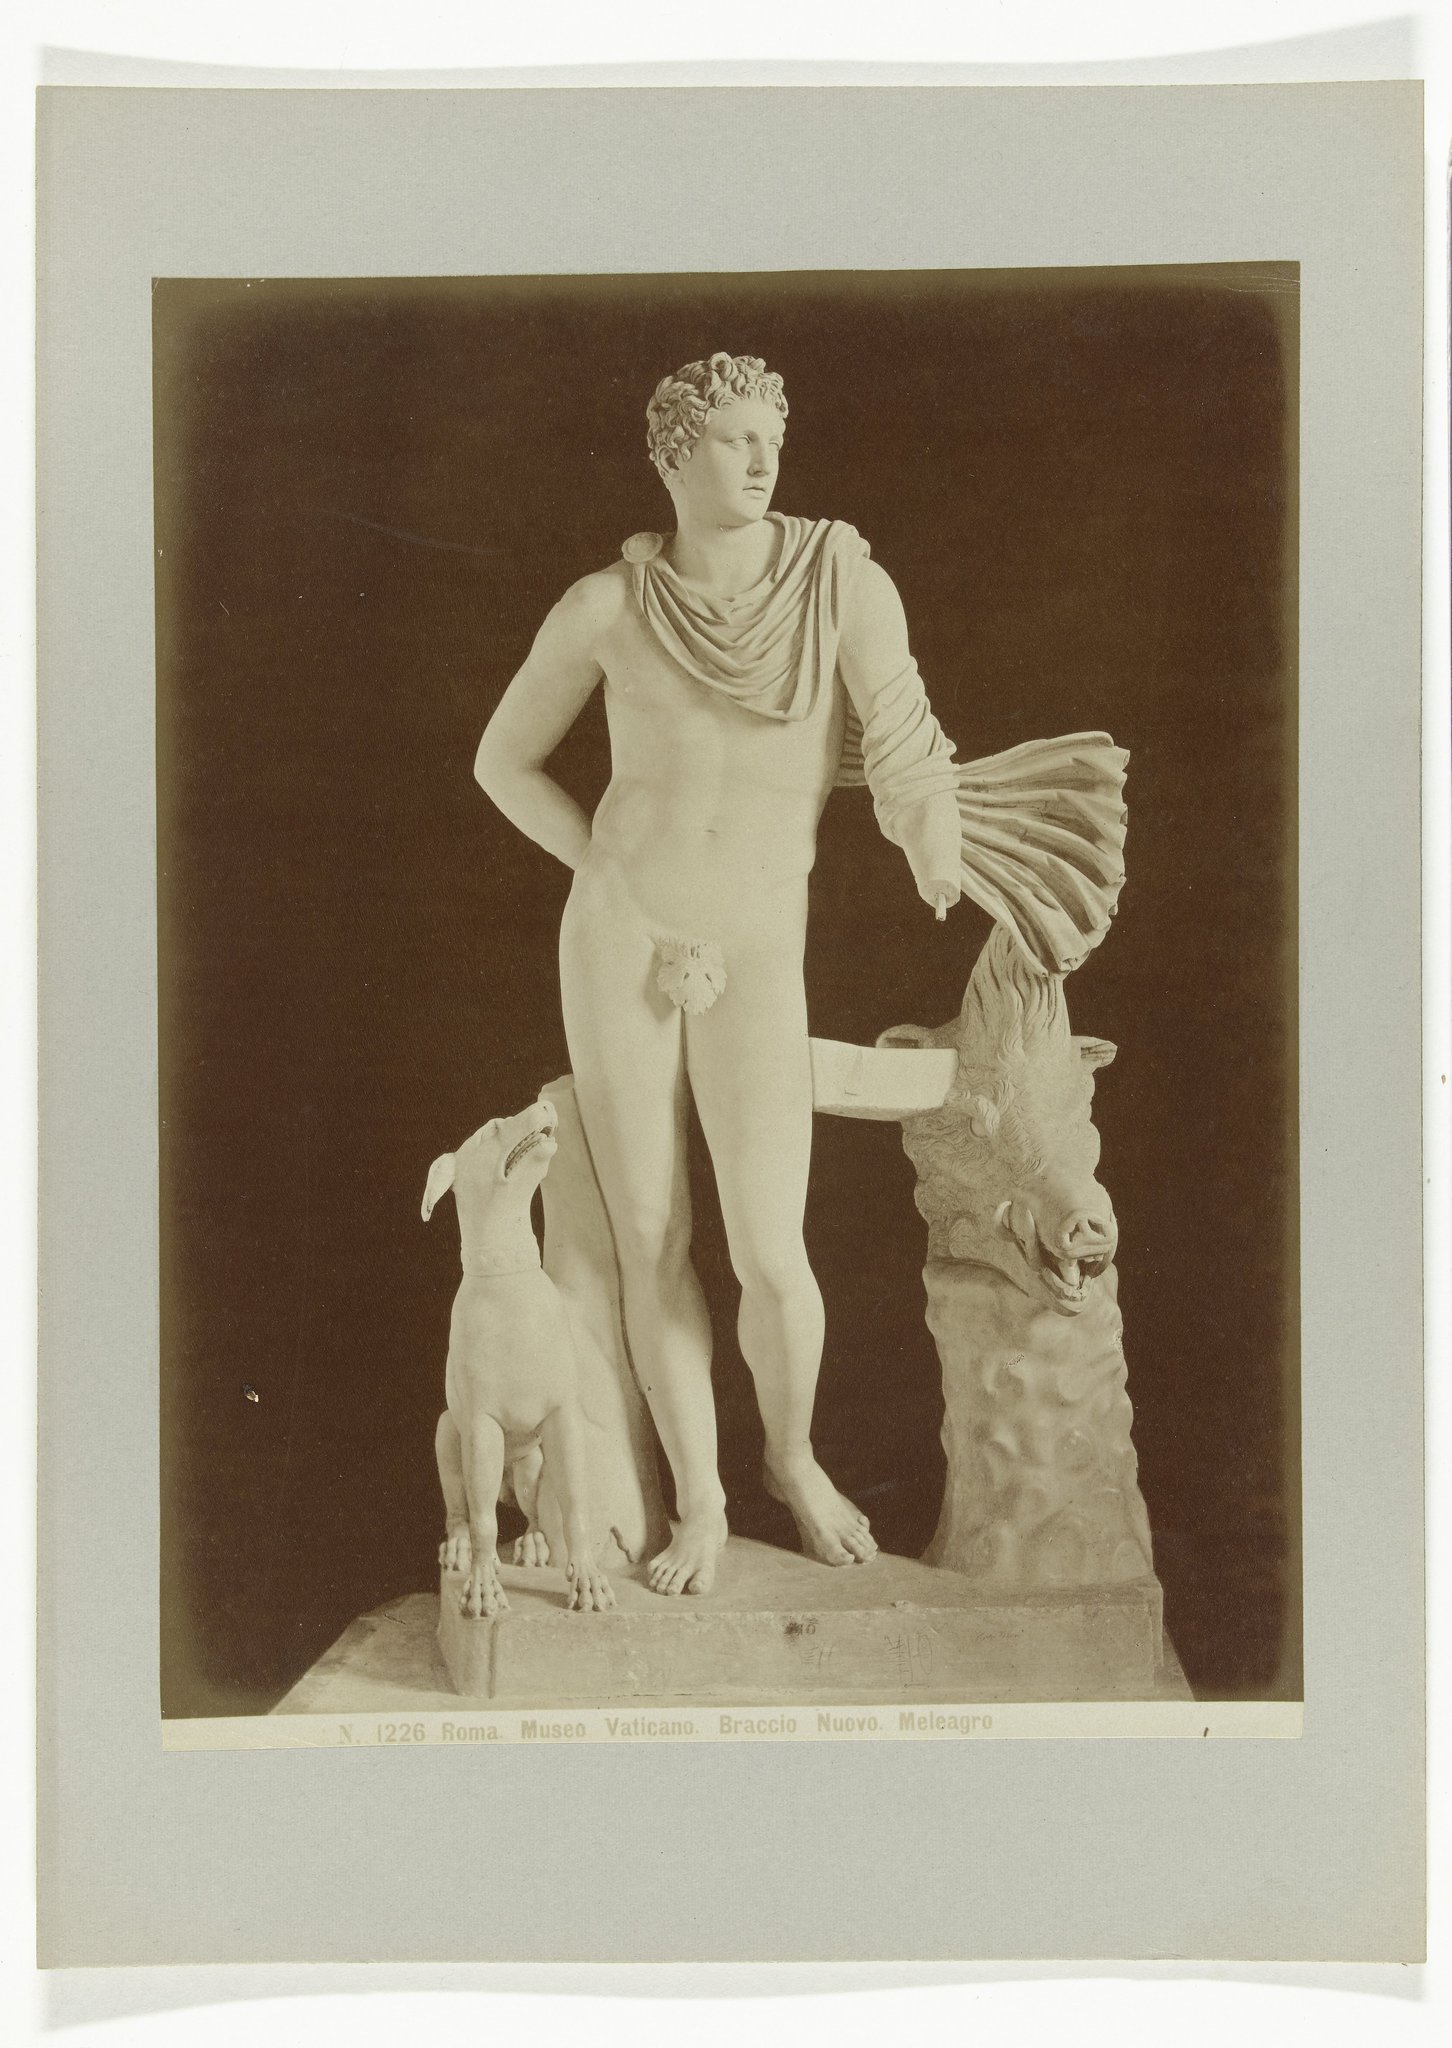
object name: photograph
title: Sculptuur van Meleager met hond en kop van everzwijn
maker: Anonymous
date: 1880-1904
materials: cardboard, paper, photographic support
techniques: albumen print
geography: rome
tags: vaticaanse musea